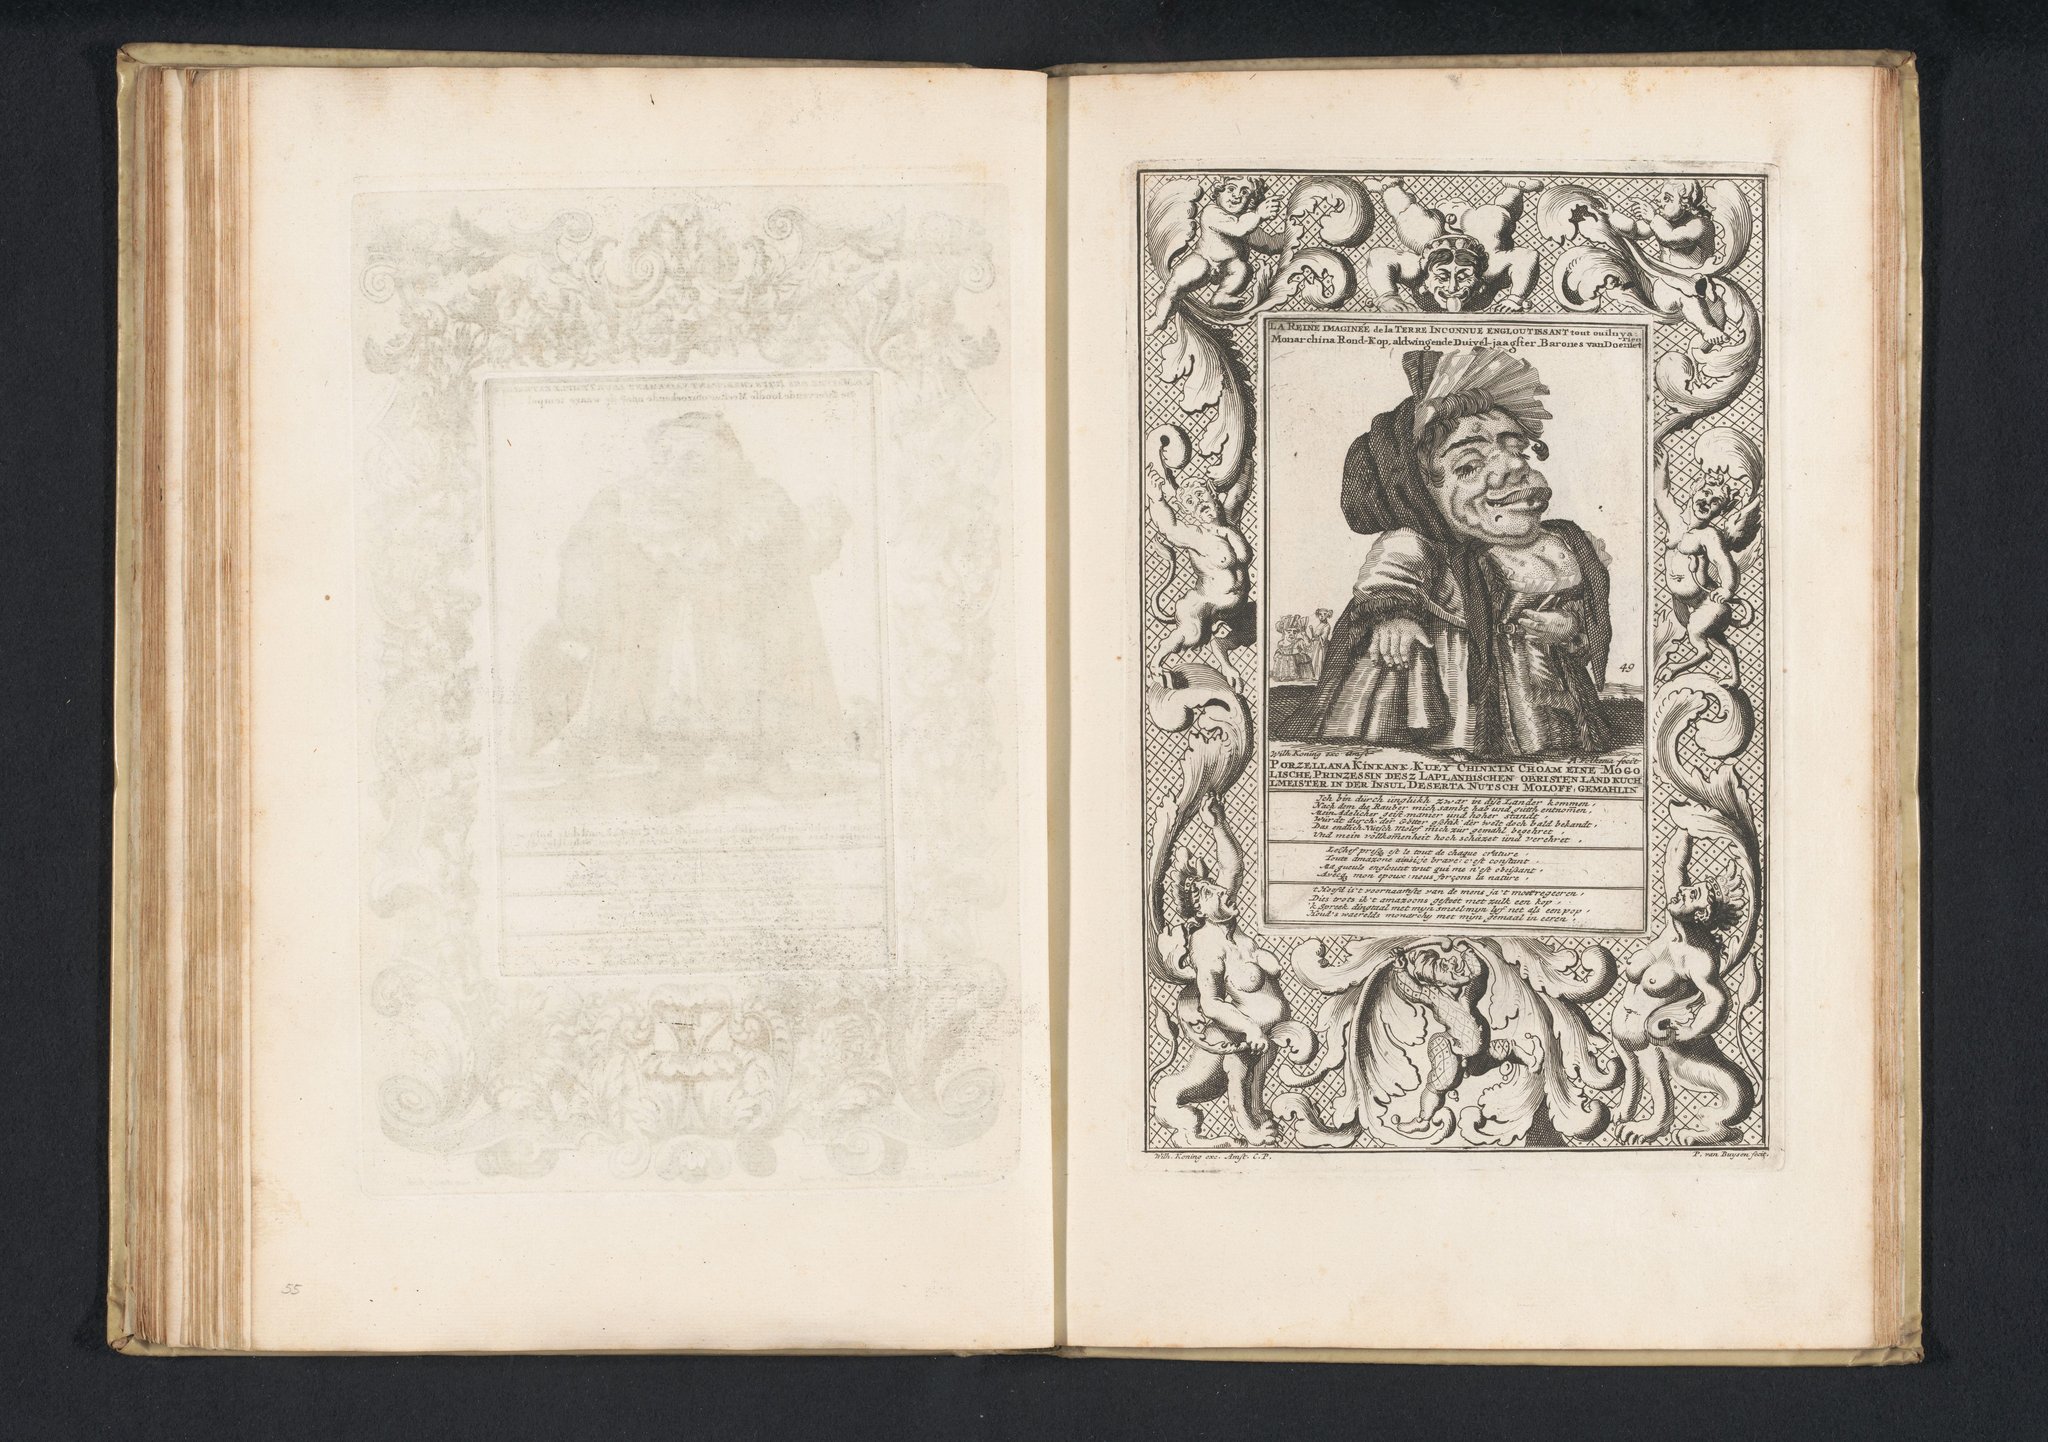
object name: caricature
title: La Reine Imaginée de la Terre Inconnue engloutissant tout ou il nya rien / Monarchina Rond-Kop, aldwingende Duivel-jaagster Barones van Doeniet / Porzellana Kinkank, Kuey Chinkim Choam Eine Mogolische Prinzessin desz Laplandischen obristen land Kuchlmeister in der Insul Deserta Nutsch Moloff, gemahlin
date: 1716-1720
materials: paper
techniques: etching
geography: northern netherlands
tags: caricatures (human types), little people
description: De kleine mens Monarchina Rond-Kop, echtgenote van Brutal-tronius van Aldwing-burg. In het onderschrift verzen in het Duits, Frans en Nederlands. Genummerd rechts midden: 49. Afdruk binnen een decoratieve omlijsting gedrukt van een aparte plaat met monsters en een harlekijn. Onderdeel van deel II in de tweede Nederlandse gebonden uitgave uit 1720 (en gerelateerd aan de Windhandel in dat jaar) van een serie karikaturen van kleine mensen, bekend als Het Dwergentooneel, deels gekopieerd naar een ouder Duits voorbeeld.